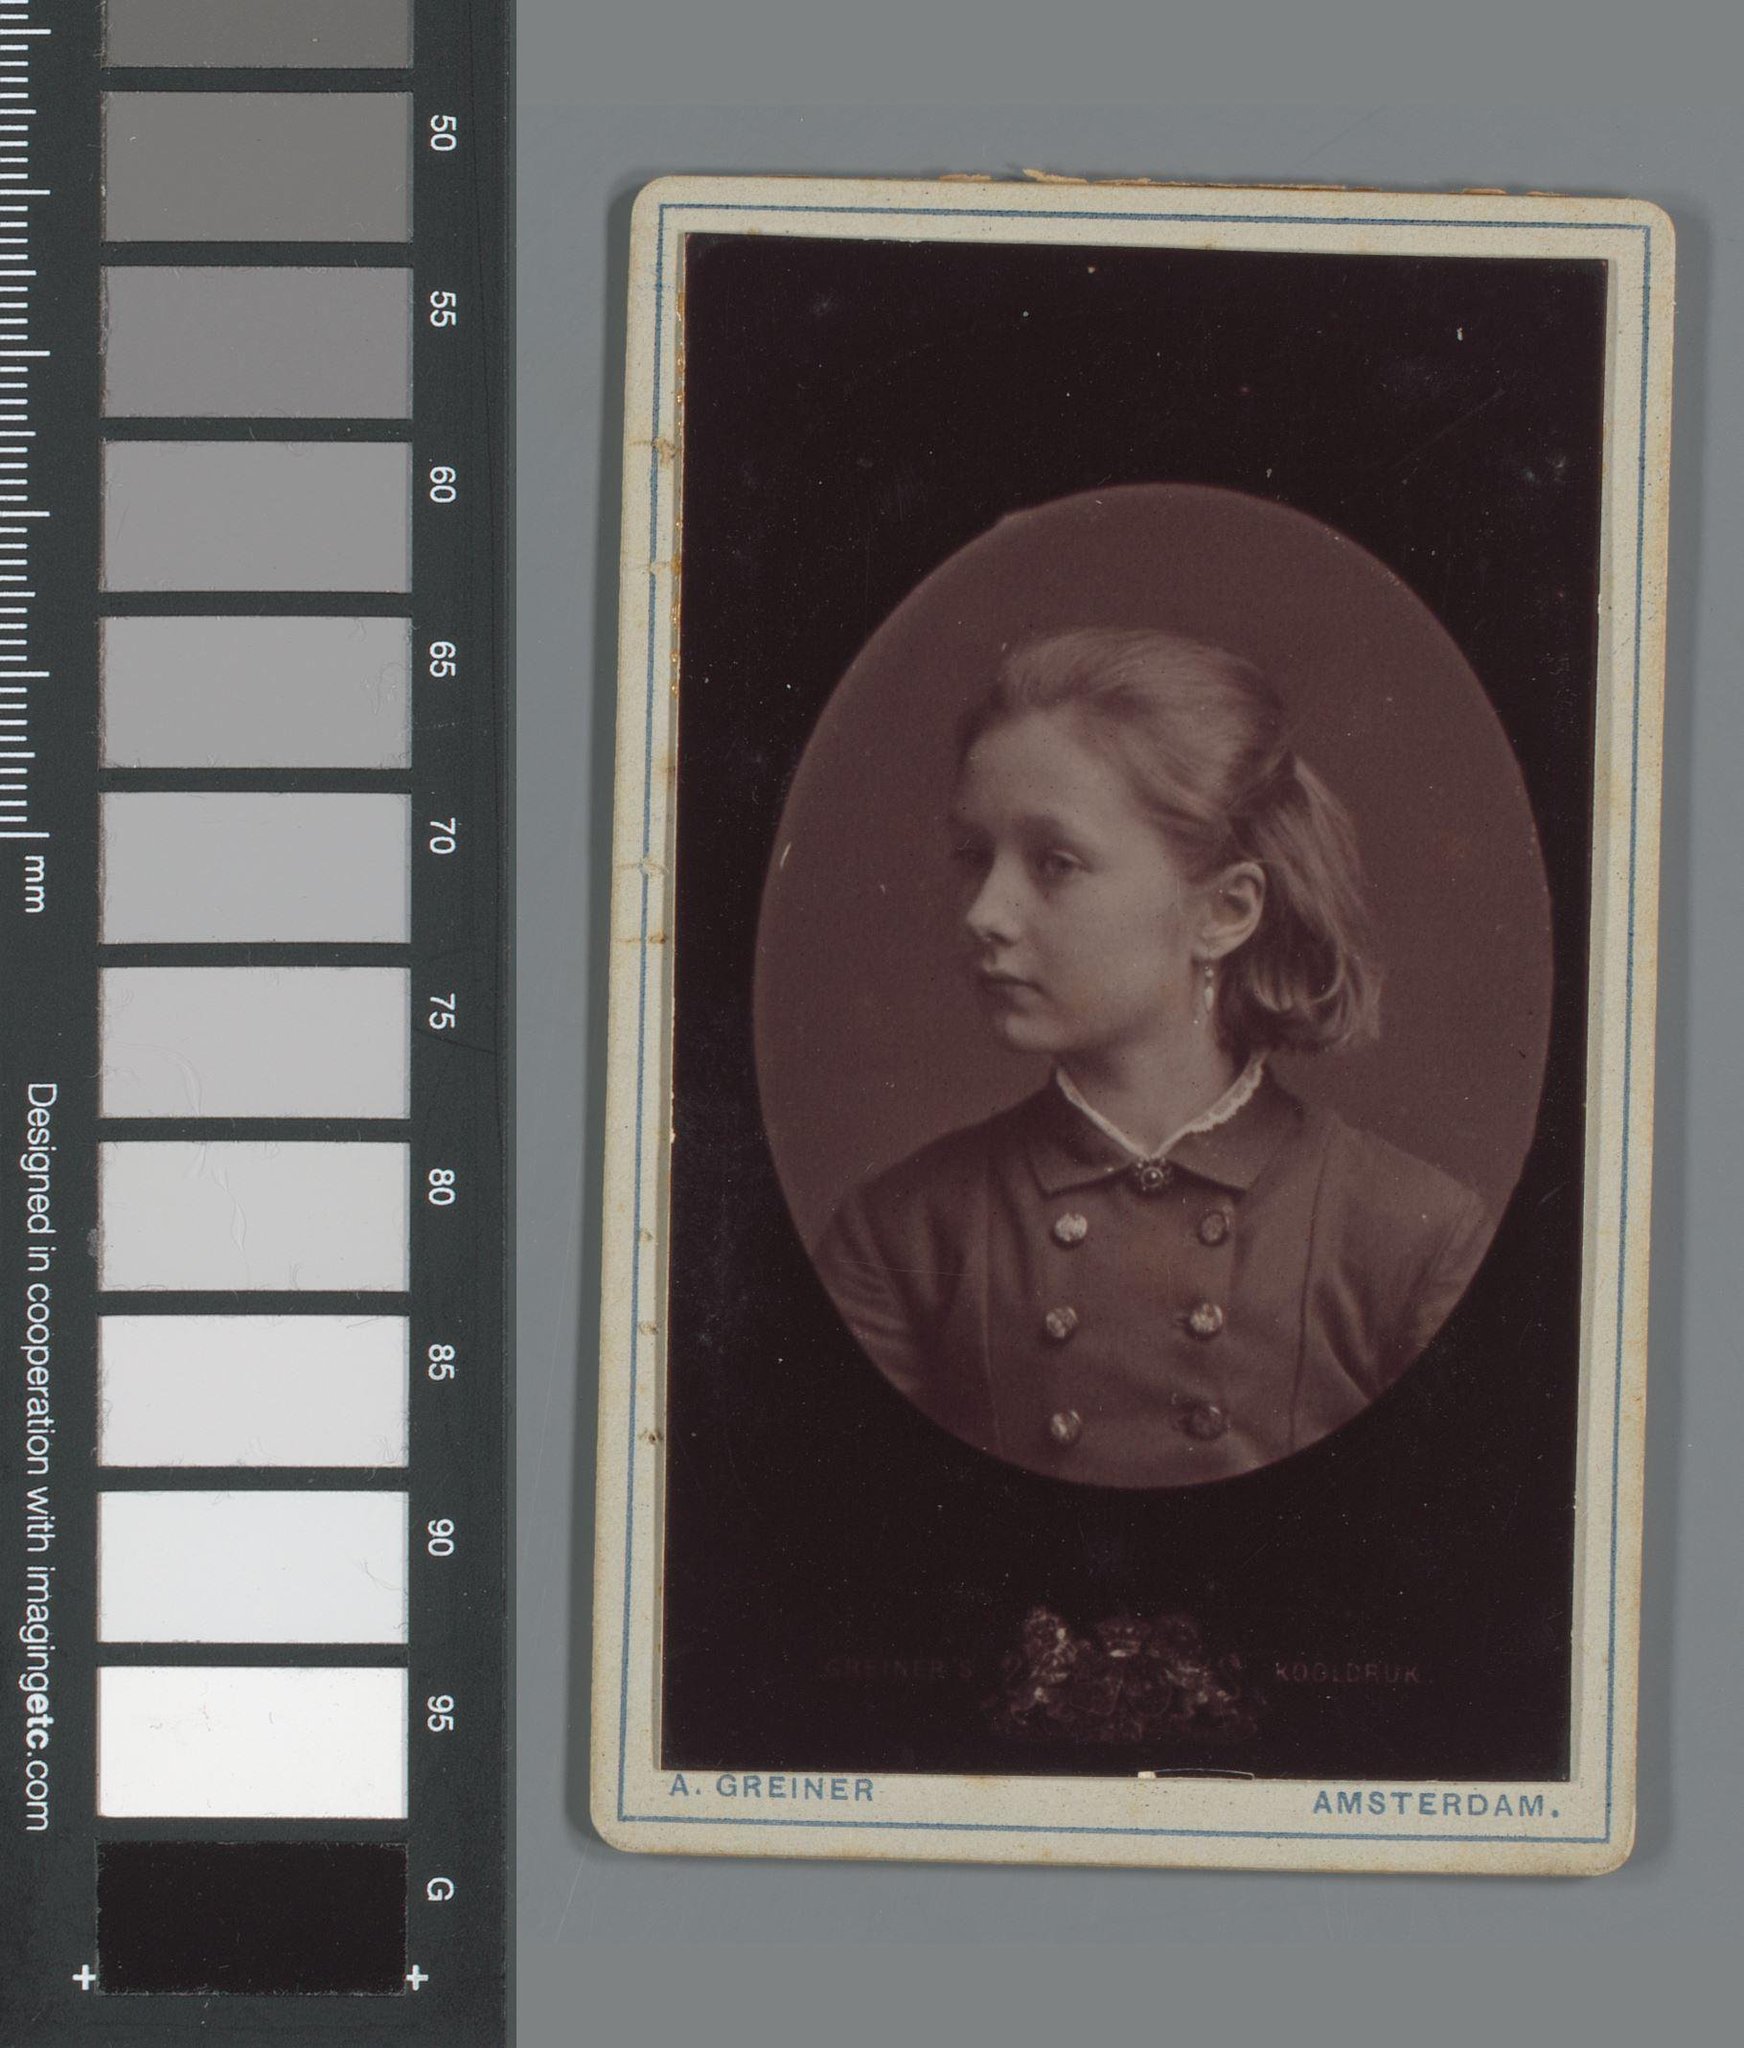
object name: carte de visite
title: Portret van Johanna Geertruida Jonker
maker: albert greiner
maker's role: fotograaf, fotostudio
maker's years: 1833-1890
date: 1865-1890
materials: cardboard, paper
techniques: carbon print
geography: amsterdam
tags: historical persons, amsterdam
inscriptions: inscription: ‘Overanderlyke Kooldruk’, workshop stamp: ‘A. Greiner/ Photograph/ Nieuwendijk L. 87, Amsterdam’